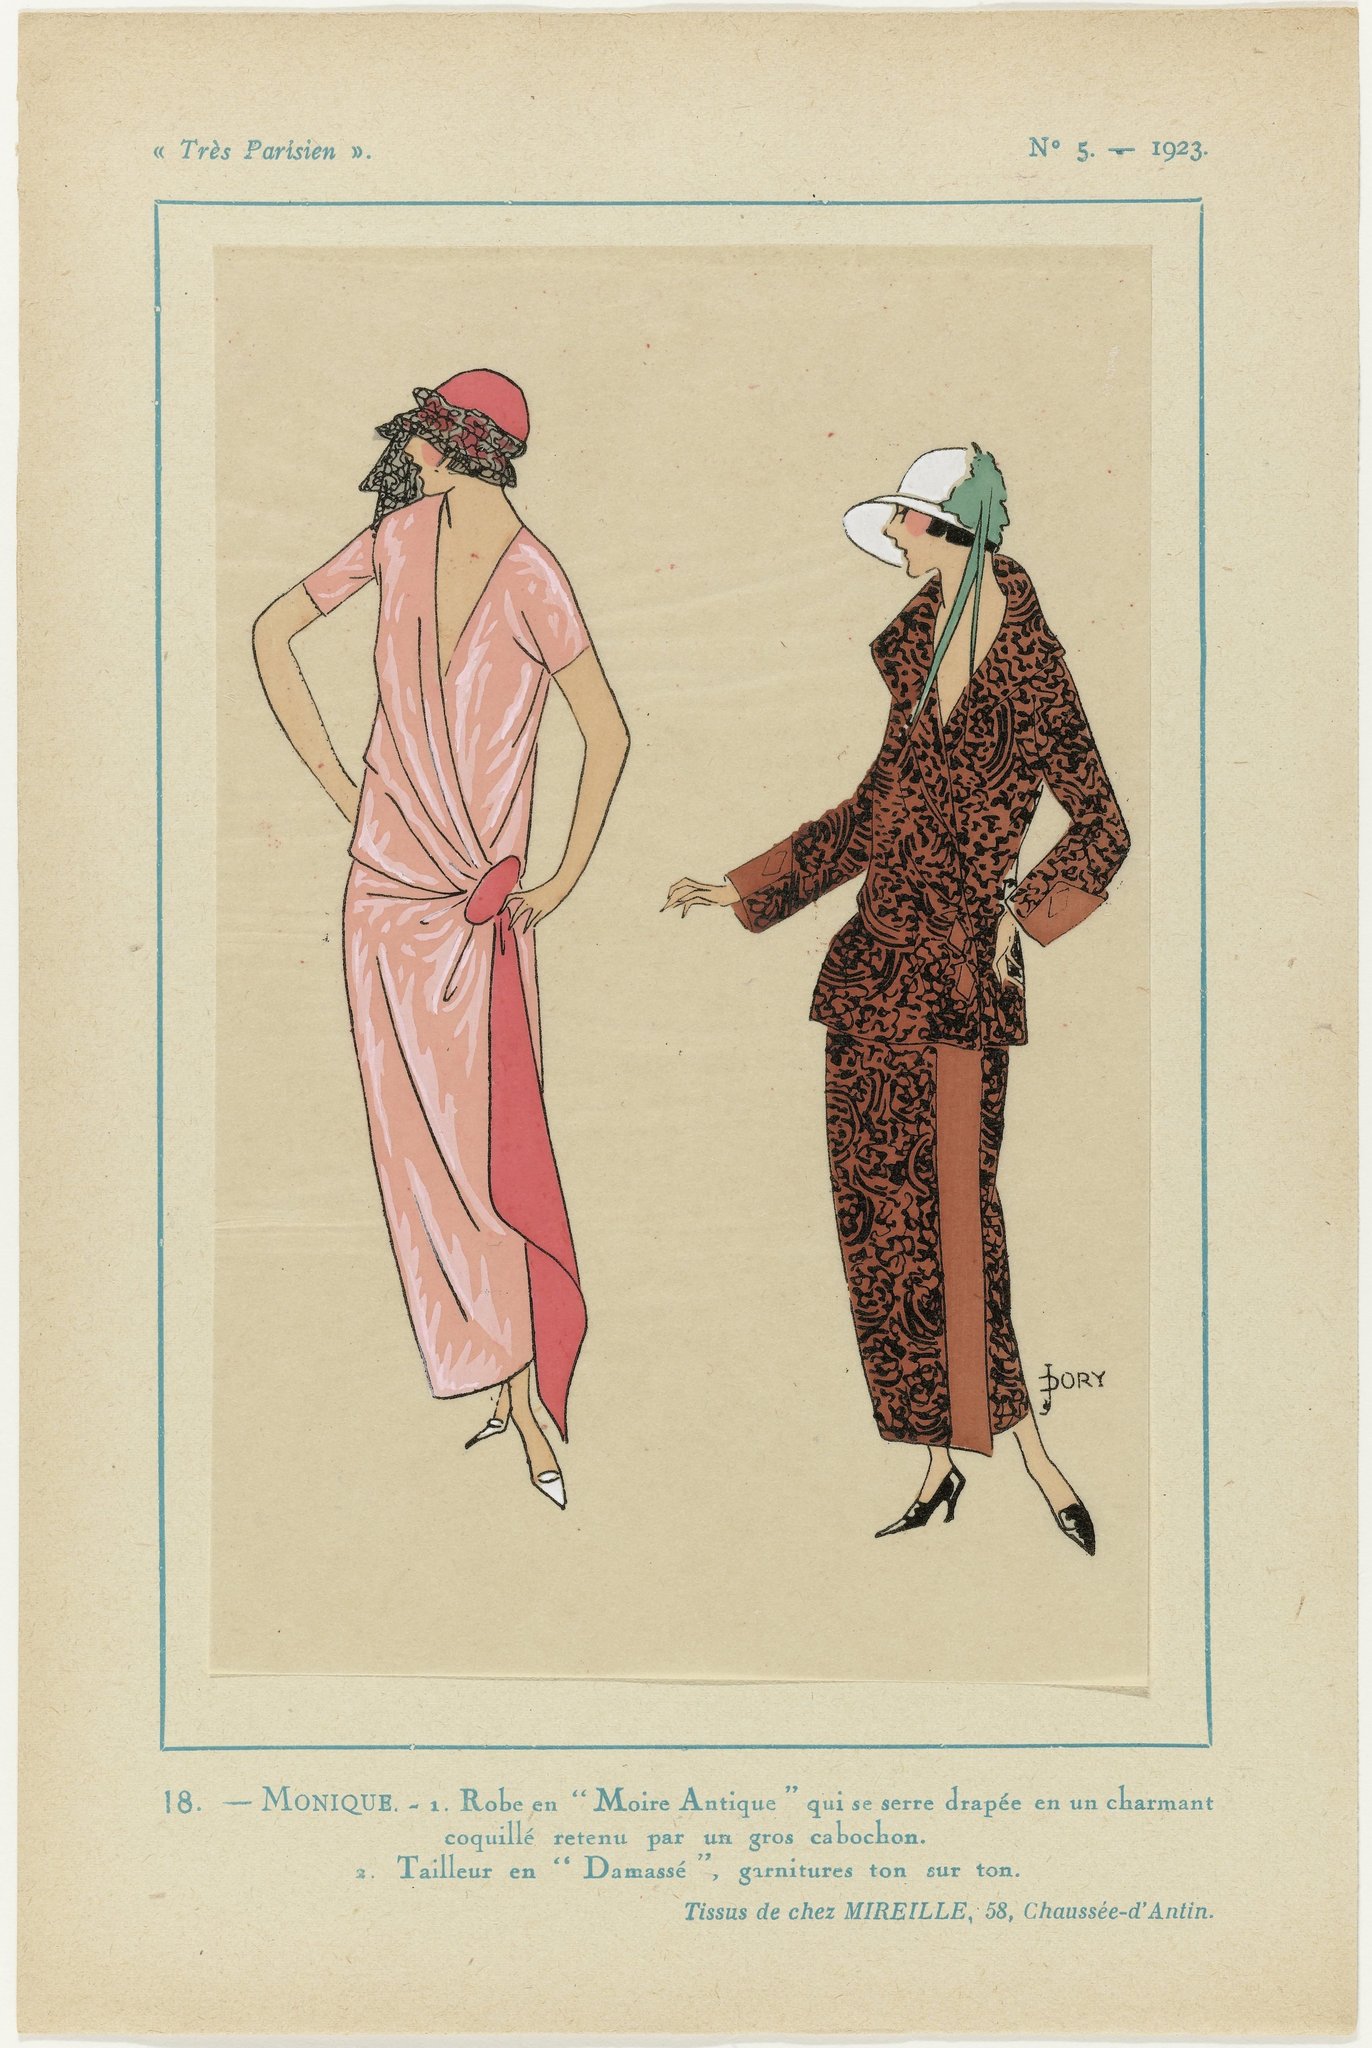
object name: fashion print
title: Très Parisien, 1923, No 5: 18.-MONIQUE. - 1. Robe en "Moire Autique"...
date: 1923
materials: paper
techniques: hand coloring, letterpress printing, lithography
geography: paris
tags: border, ribbon, braid (+ women's clothes), ensembles of pieces of clothing (suit) (+ women's clothes), fashion plates, dress, gown (+ women's clothes)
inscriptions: caption: ‘18. - MONIQUE.- 1. Robe en "Moire Antique" qui se serre drapée en un charmant coquillé retenu par un gros cabochon. 2. Tailleur en "Damassé", garnitures ton sur ton. / Tissus de chez MIREILLE, 58, Chaussée- d'Antin.’, title: ‘Très Parisien / No 5. - 1923’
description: 1. Jurk van "Moire Antique", die is gedrapeerd en vastgemaakt met een grote cabochon. 2. Tailleur (mantelpak) van "Damassé", garneringen in dezelfde kleur. Stoffen van Mireille. Accessoires: cloche (pothoed), pumps. Prent uit het modetijdschrift Très Parisien (1920-1936).